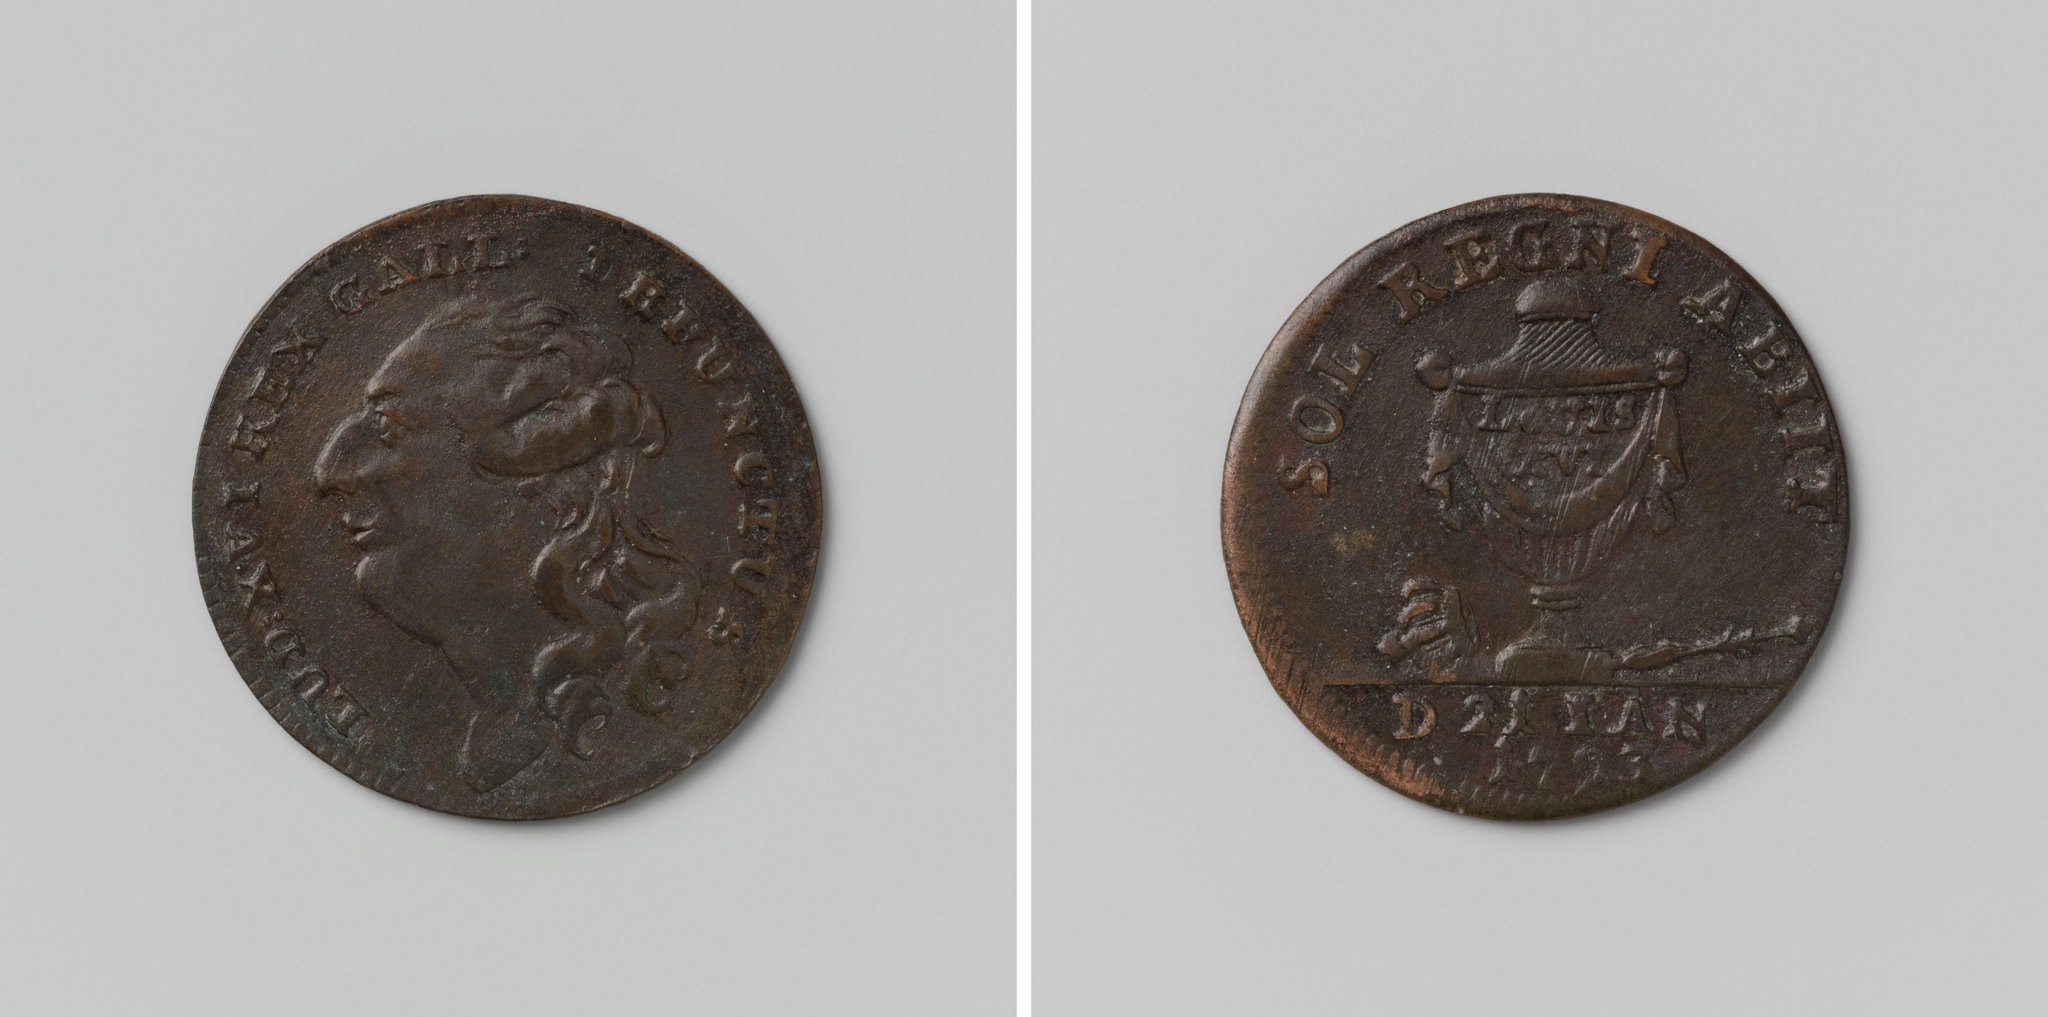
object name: jeton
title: Terechtstelling van Lodewijk XVI, koning van Frankrijk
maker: Anonymous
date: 1793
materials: copper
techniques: striking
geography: france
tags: paris, lodewijk xvi (koning van frankrijk)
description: Koperen penning. Voorzijde: borststuk man binnen omschrift. Keerzijde: lijkbus met opschrift staande tussen scepter en kroon binnen omschrift; afsnede: datering